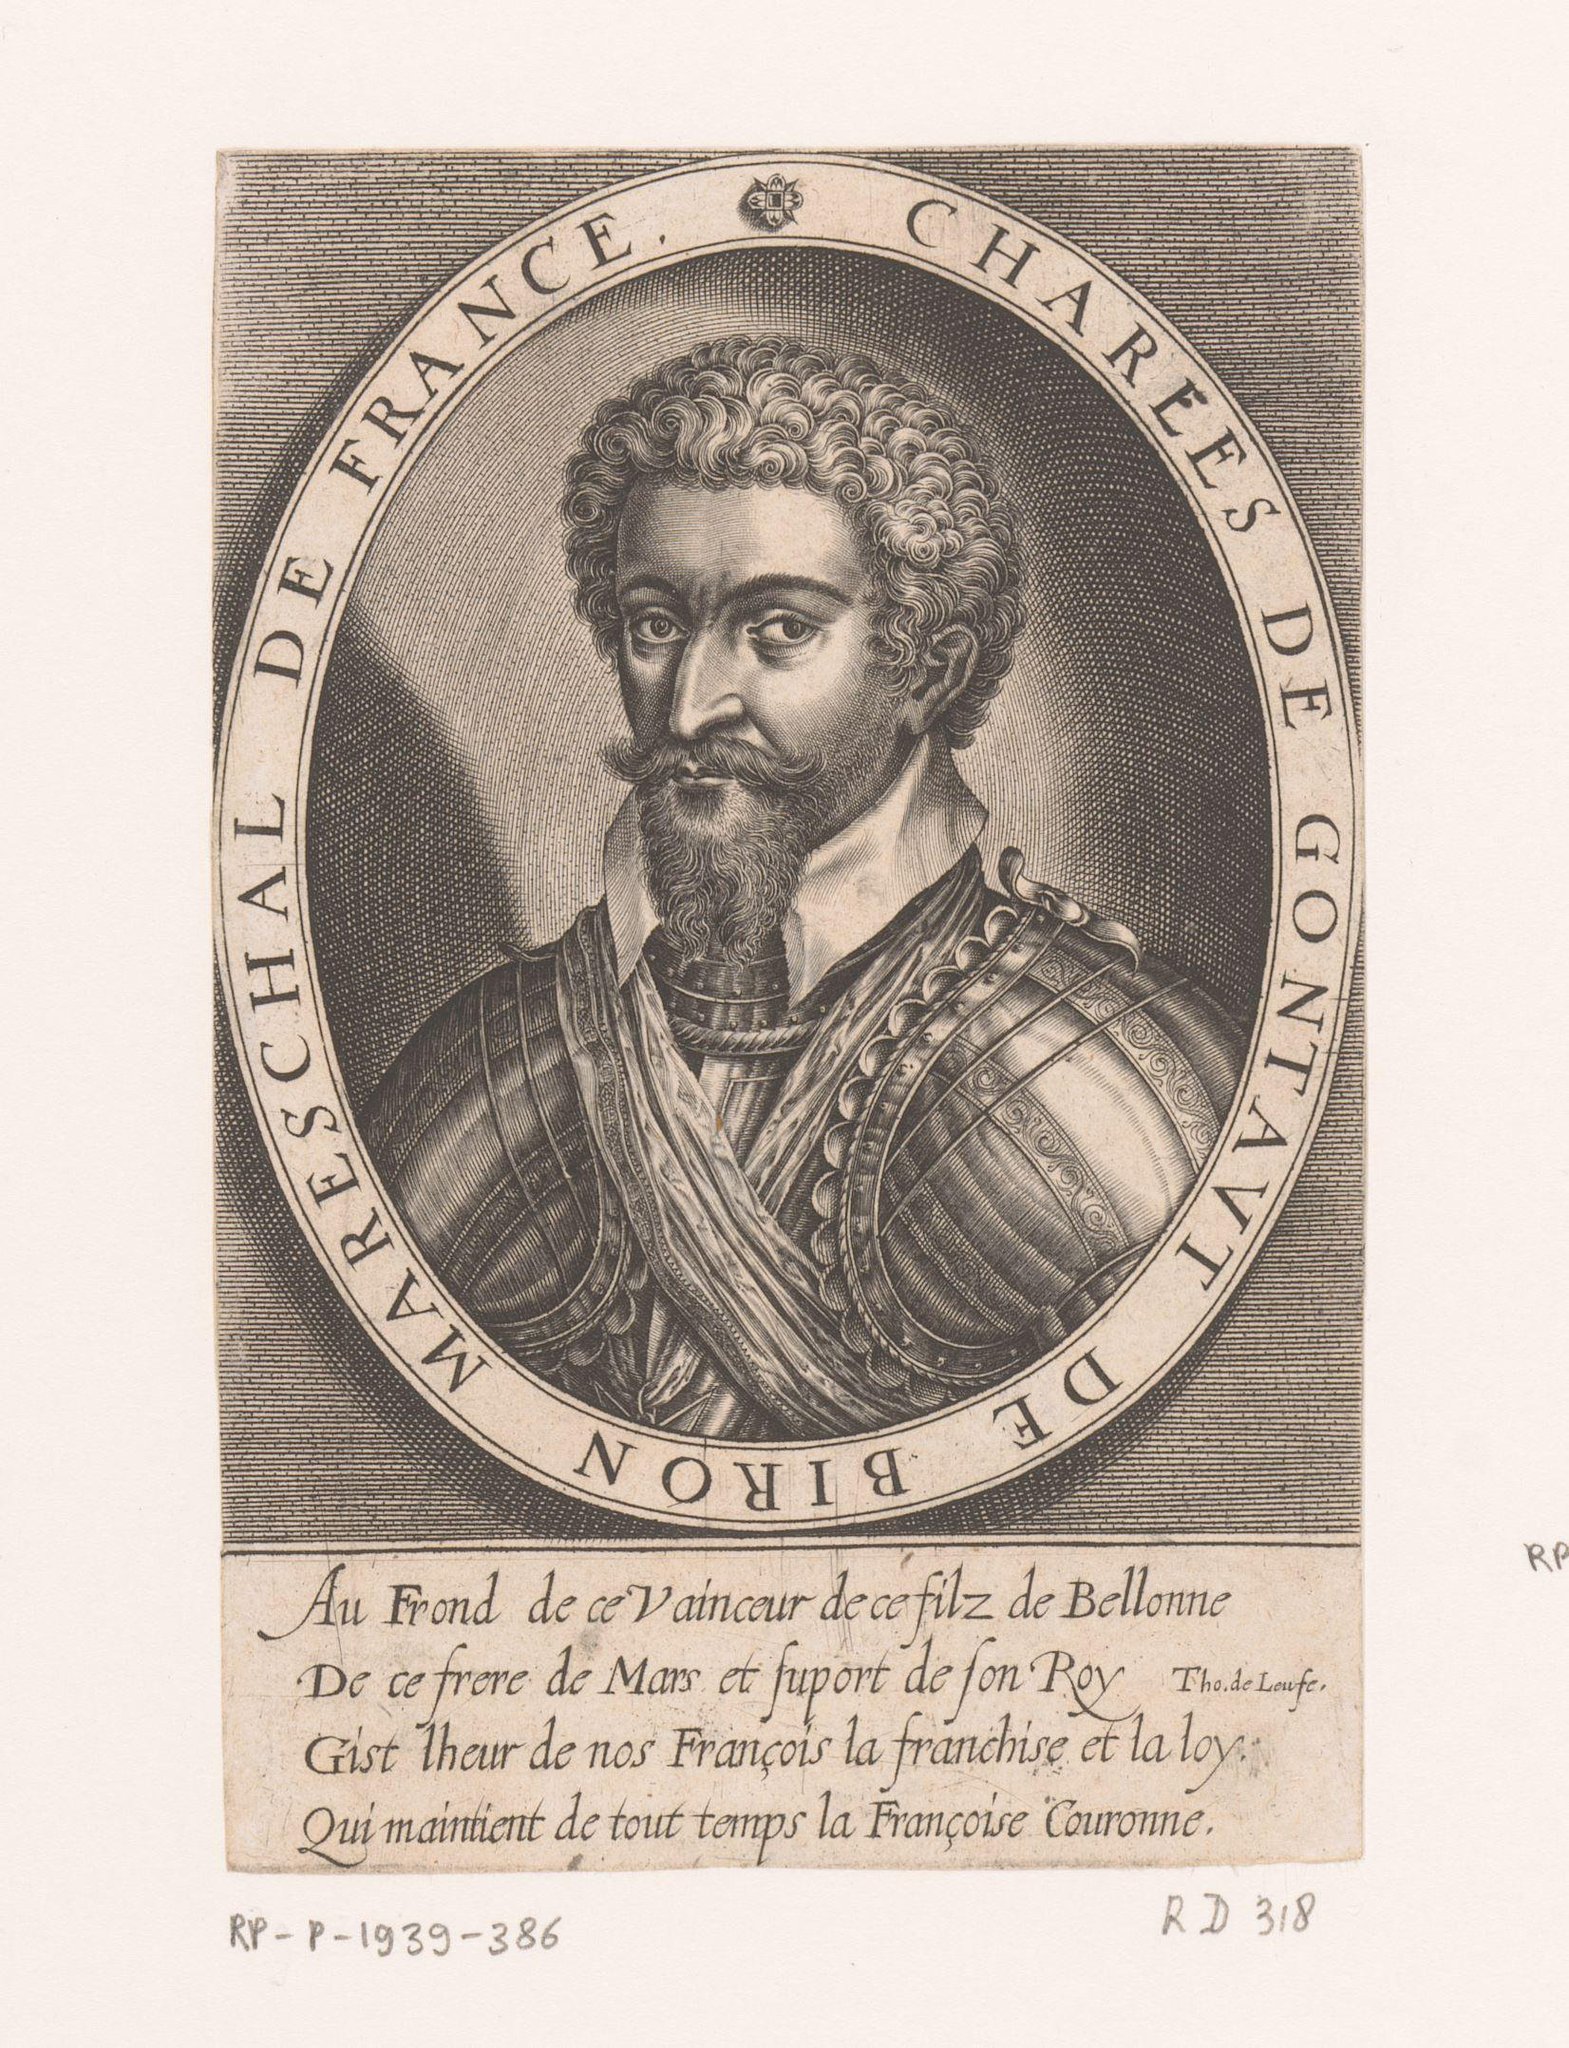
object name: print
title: Portret van Charles de Gontaut heer van Biron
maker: thomas de leu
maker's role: print maker, publisher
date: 1576-1614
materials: paper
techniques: engraving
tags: paris, cuirass, historical persons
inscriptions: collector's mark: Lugt 151, collector's mark: Lugt 2760, collector's mark: Lugt 2166